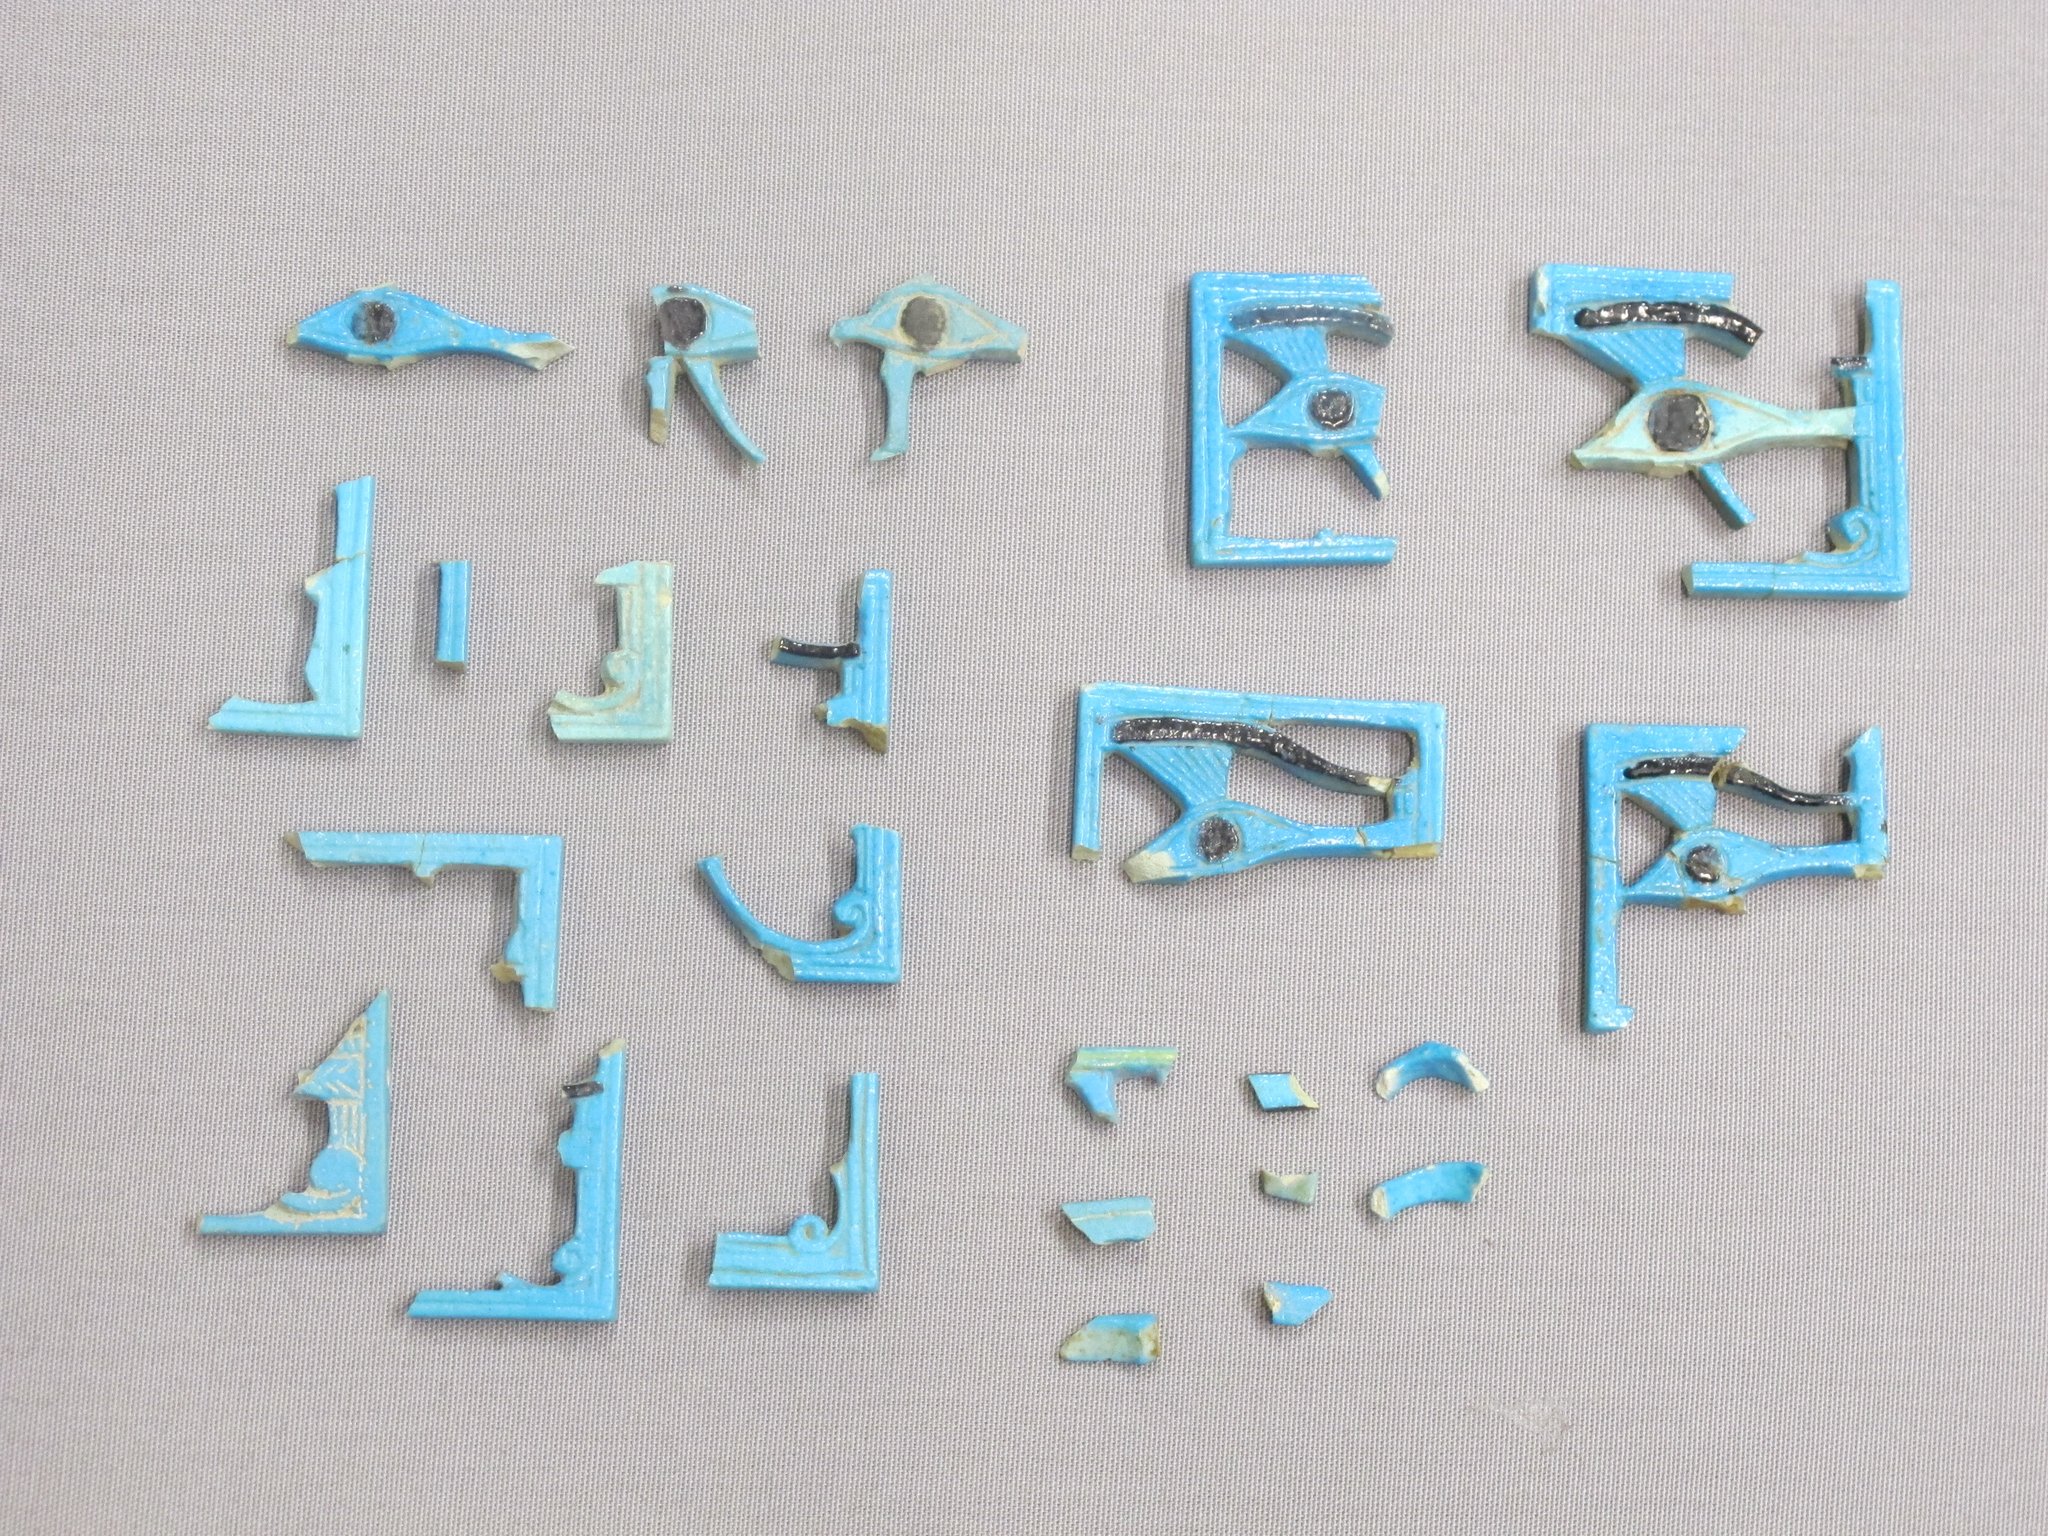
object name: amulet fragment, from rectangular wedjat eye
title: Fragments of wedjat eye amulets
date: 1070-343 BCE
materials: faience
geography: egypt